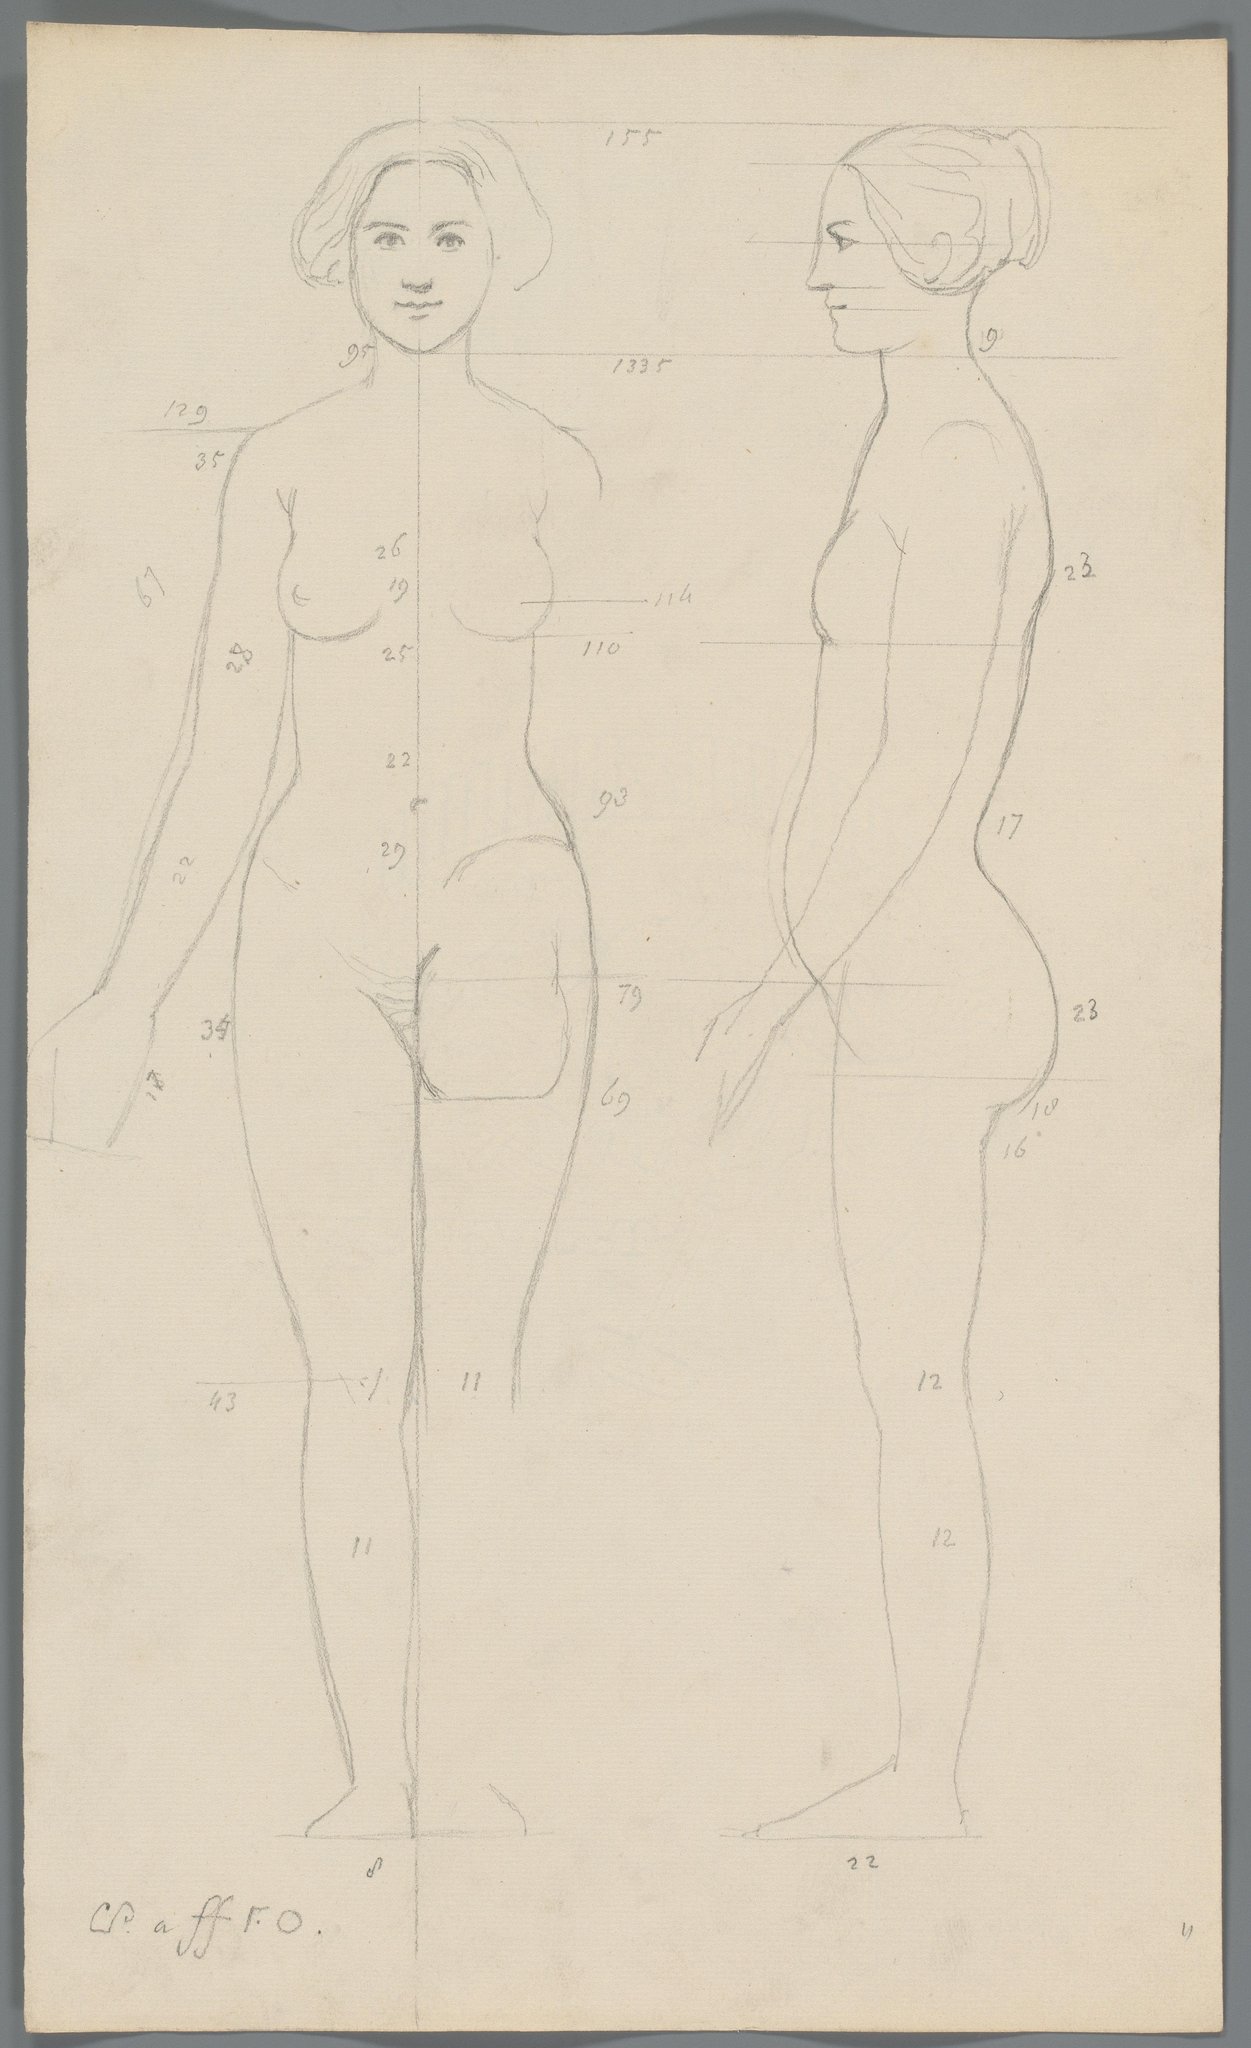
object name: drawing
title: Proportiestudie van een vrouw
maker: jacobus everhardus josephus van den berg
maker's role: draughtsman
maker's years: 1802-1861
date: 1812-1861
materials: paper, pencil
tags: standing figure (canon, proportions) - aa - female human figure, anatomy (non-medical) - aa - female human figure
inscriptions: inscription: ‘[...] a ff [...]’